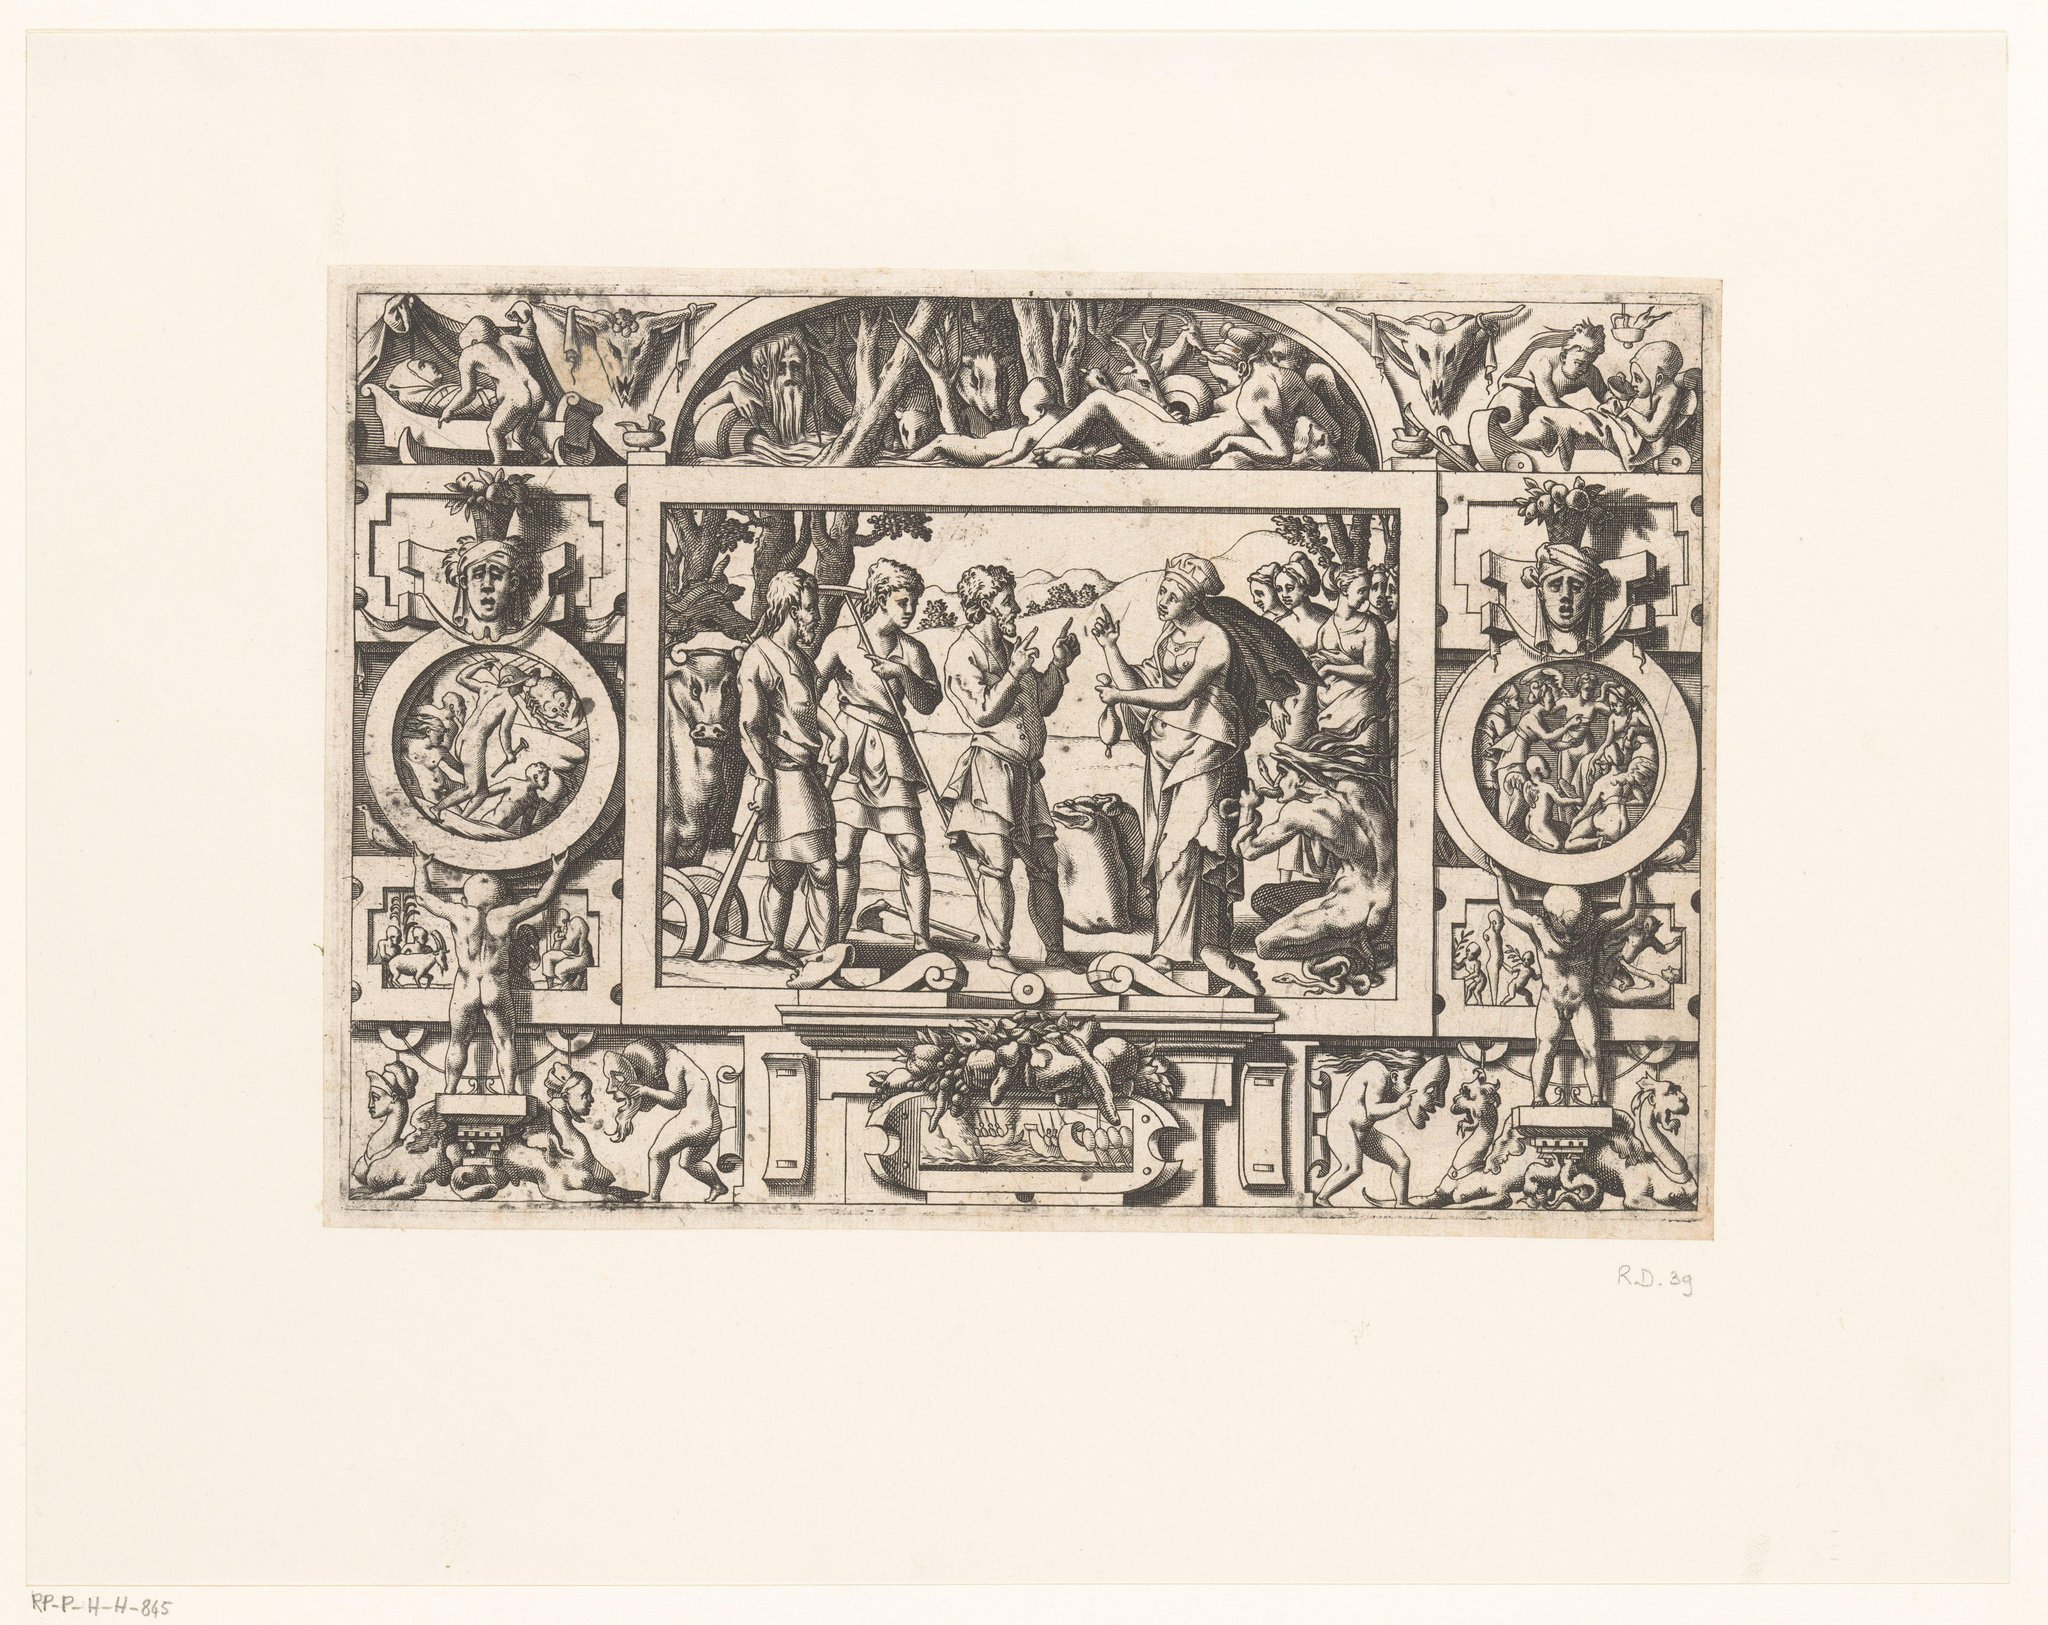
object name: print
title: Ino vergiftigt de oogst van het koninkrijk Thebe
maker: rené boyvin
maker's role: print maker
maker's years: 1525-1598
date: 1563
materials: paper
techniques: engraving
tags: aggressive, unfriendly activities and relationships of ino, poisoning, the story of the argonauts: the quest for the golden fleece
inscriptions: collector's mark: Lugt 11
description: Maakt deel uit van een serie van 26 prenten met scènes uit het verhaal van Jason en het gulden vlies, uitgegeven in 1563 te Parijs.